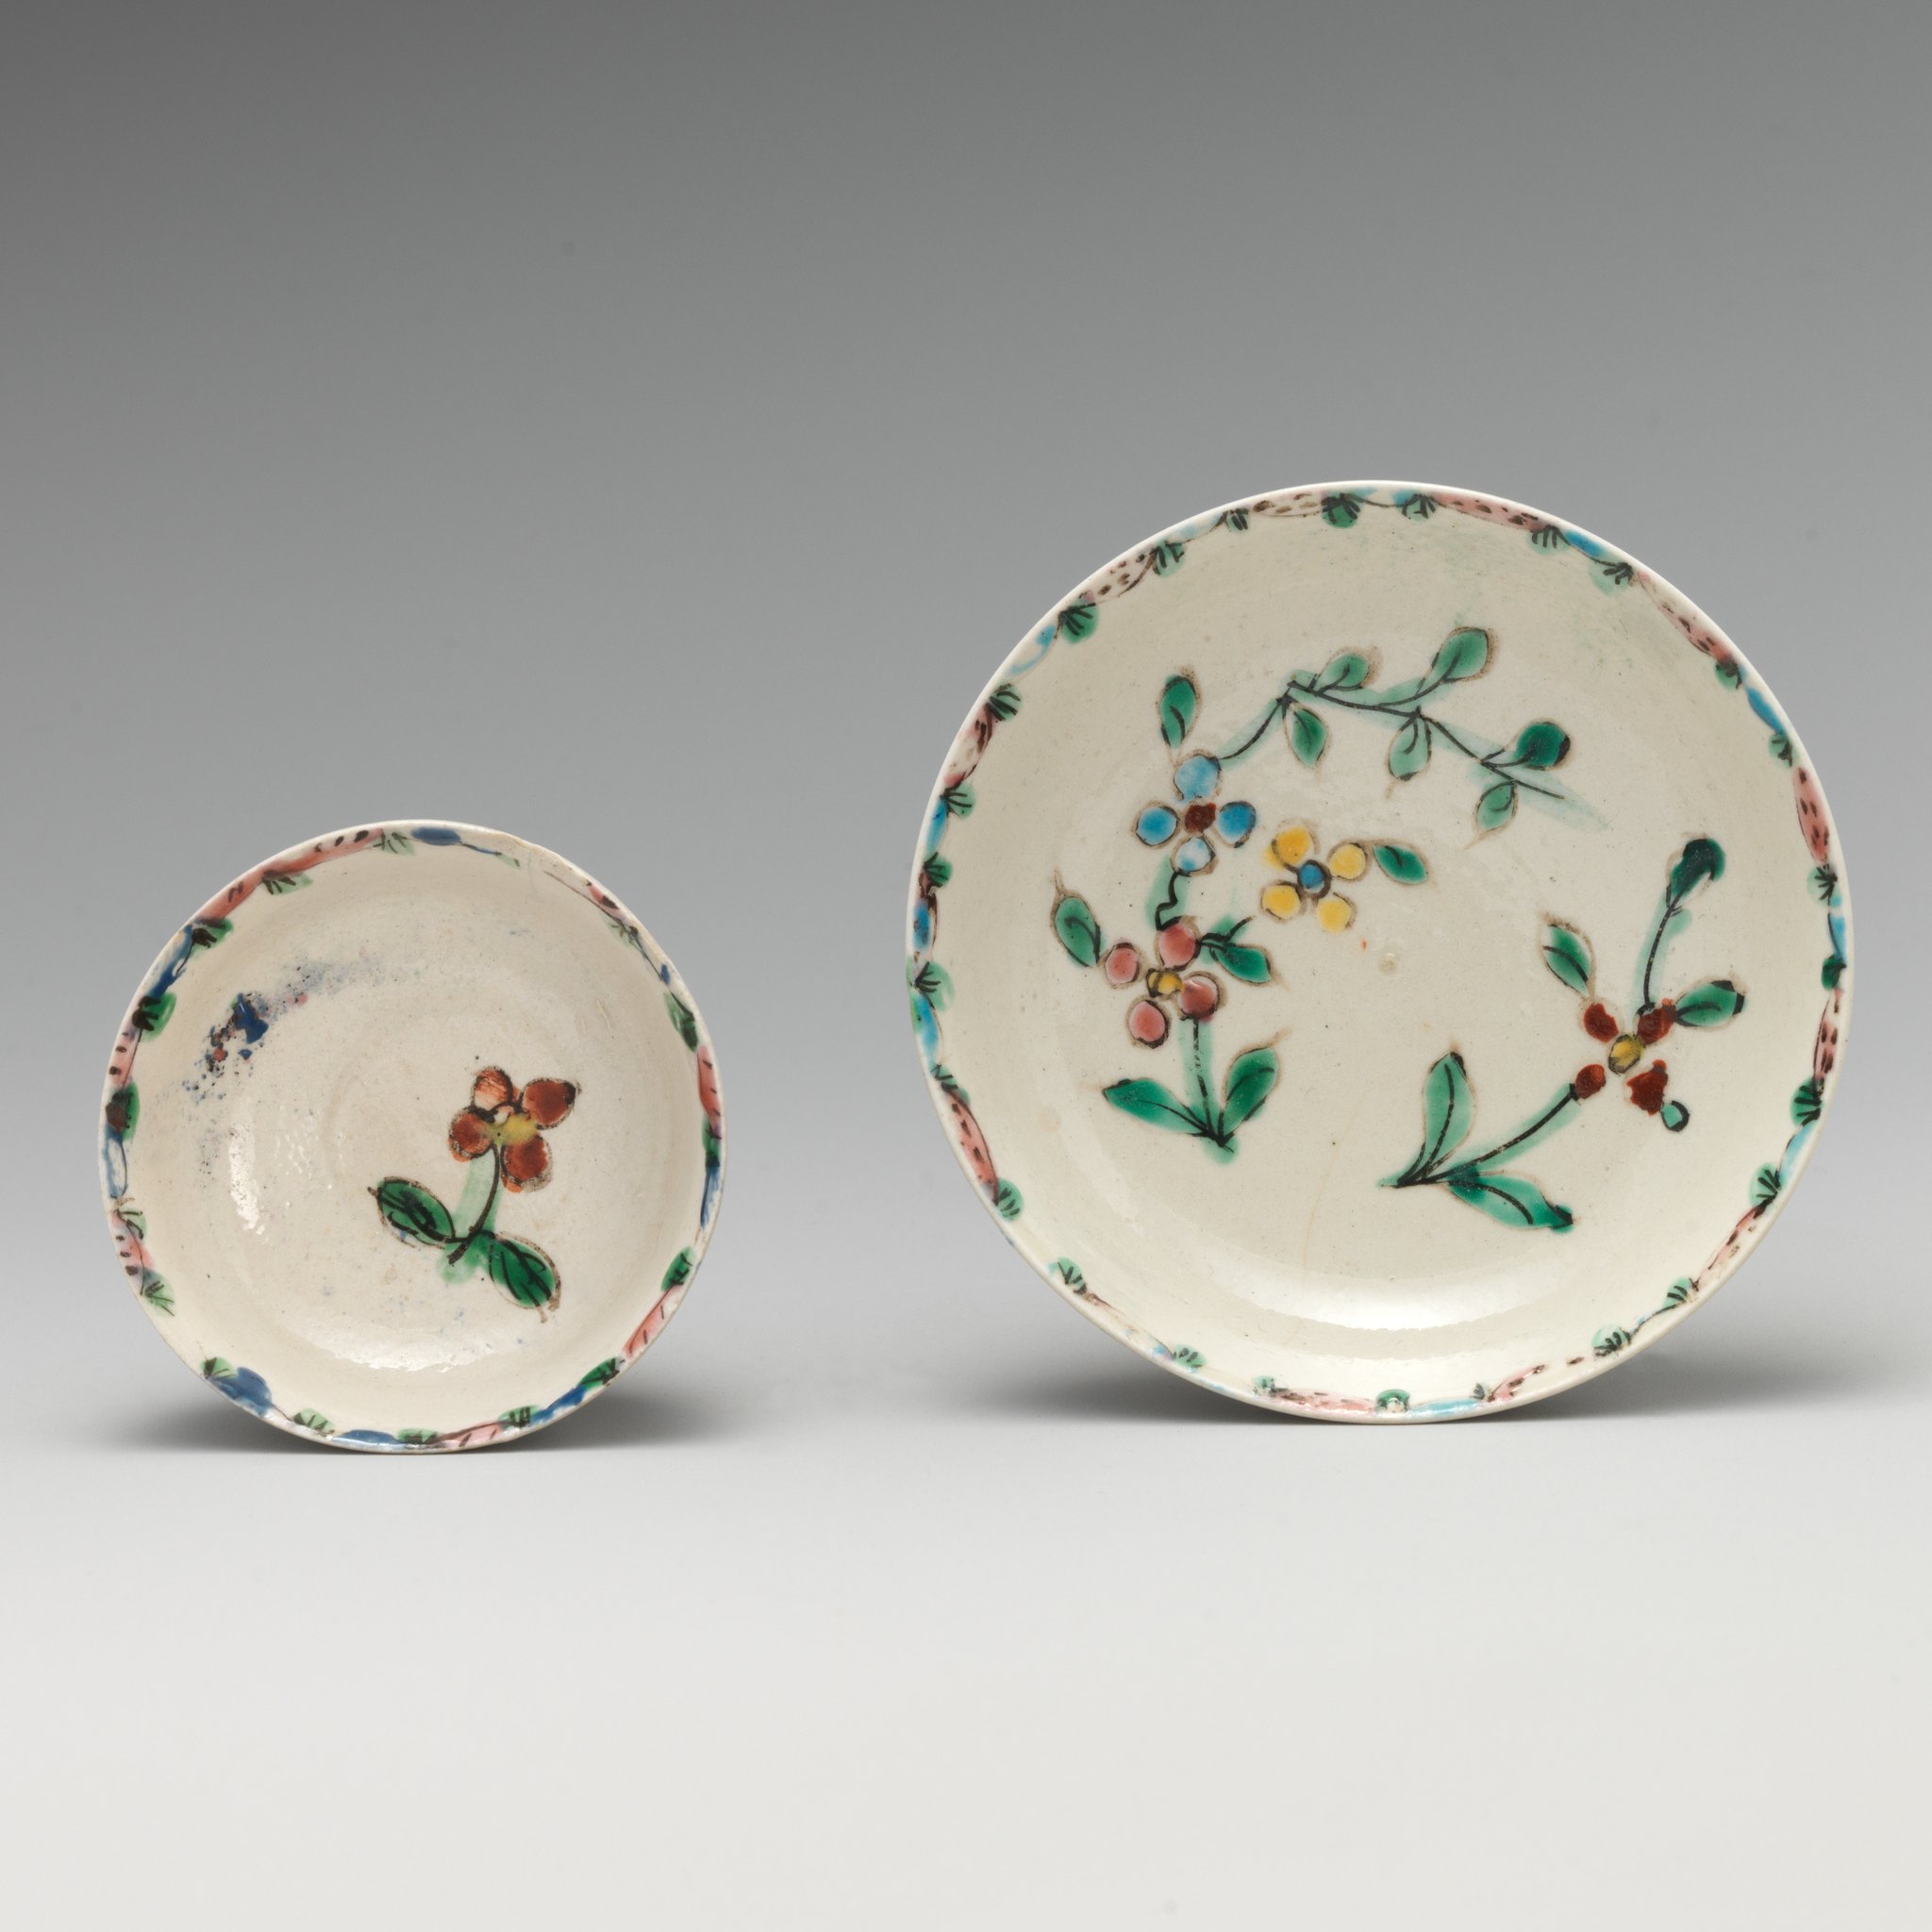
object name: cup and saucer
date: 1760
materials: stoneware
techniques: salt glaze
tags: flowers